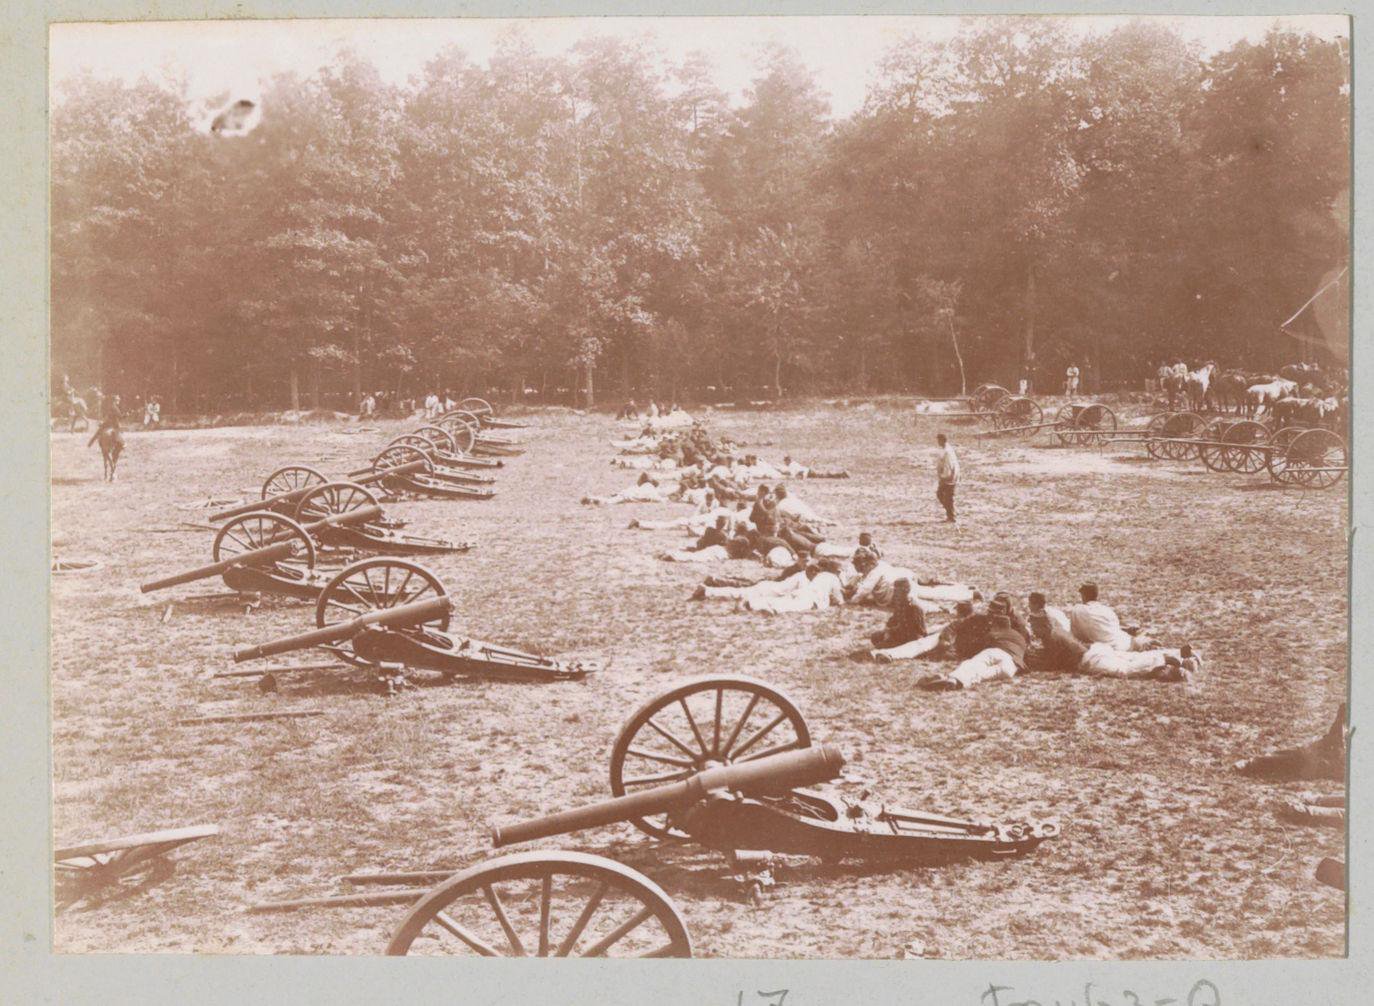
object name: photograph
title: Rustende manschappen tijdens militaire oefening met kanonnnen te Fontainebleau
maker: delizy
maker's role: manufacturer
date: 1806-1896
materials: paper, photographic support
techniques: gelatin silver print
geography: fontainebleau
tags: land forces (+ cavalry, horsemen), (military) camp with tents, manoeuvre ~ military training, firearms: cannon, resting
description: Onderdeel van Fotoalbum van een Franse amateurfotograaf met opnames van uitstapjes in Frankrijk, Spanje, België, Luxemburg en Nederland, de eerste automobielen en autoraces.